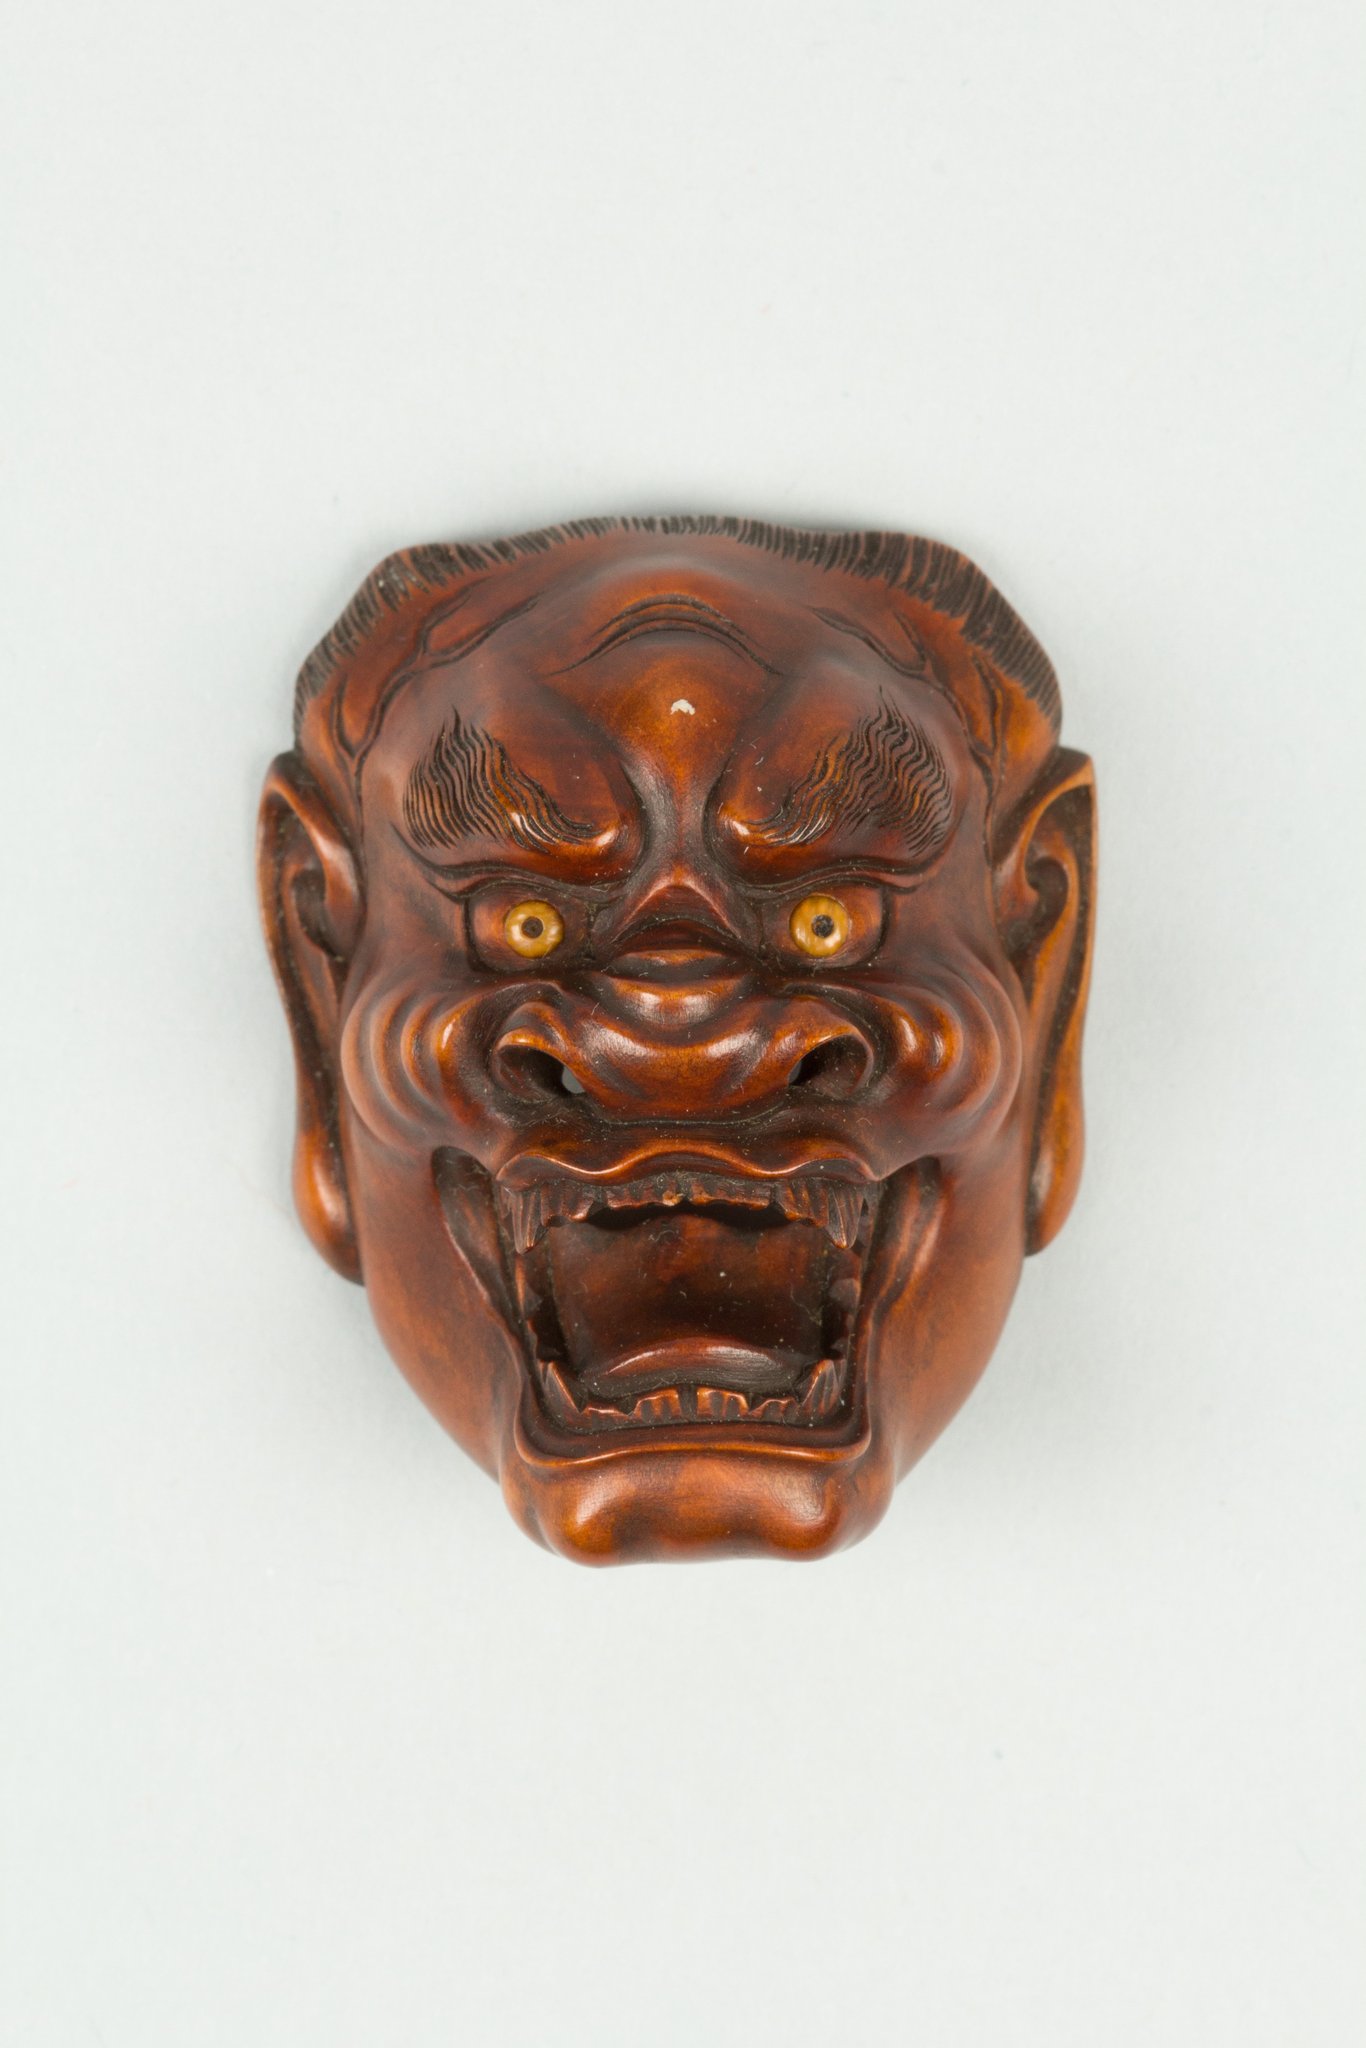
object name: netsuke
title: Netsuke of Mask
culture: japanese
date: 1801-1900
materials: wood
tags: masks